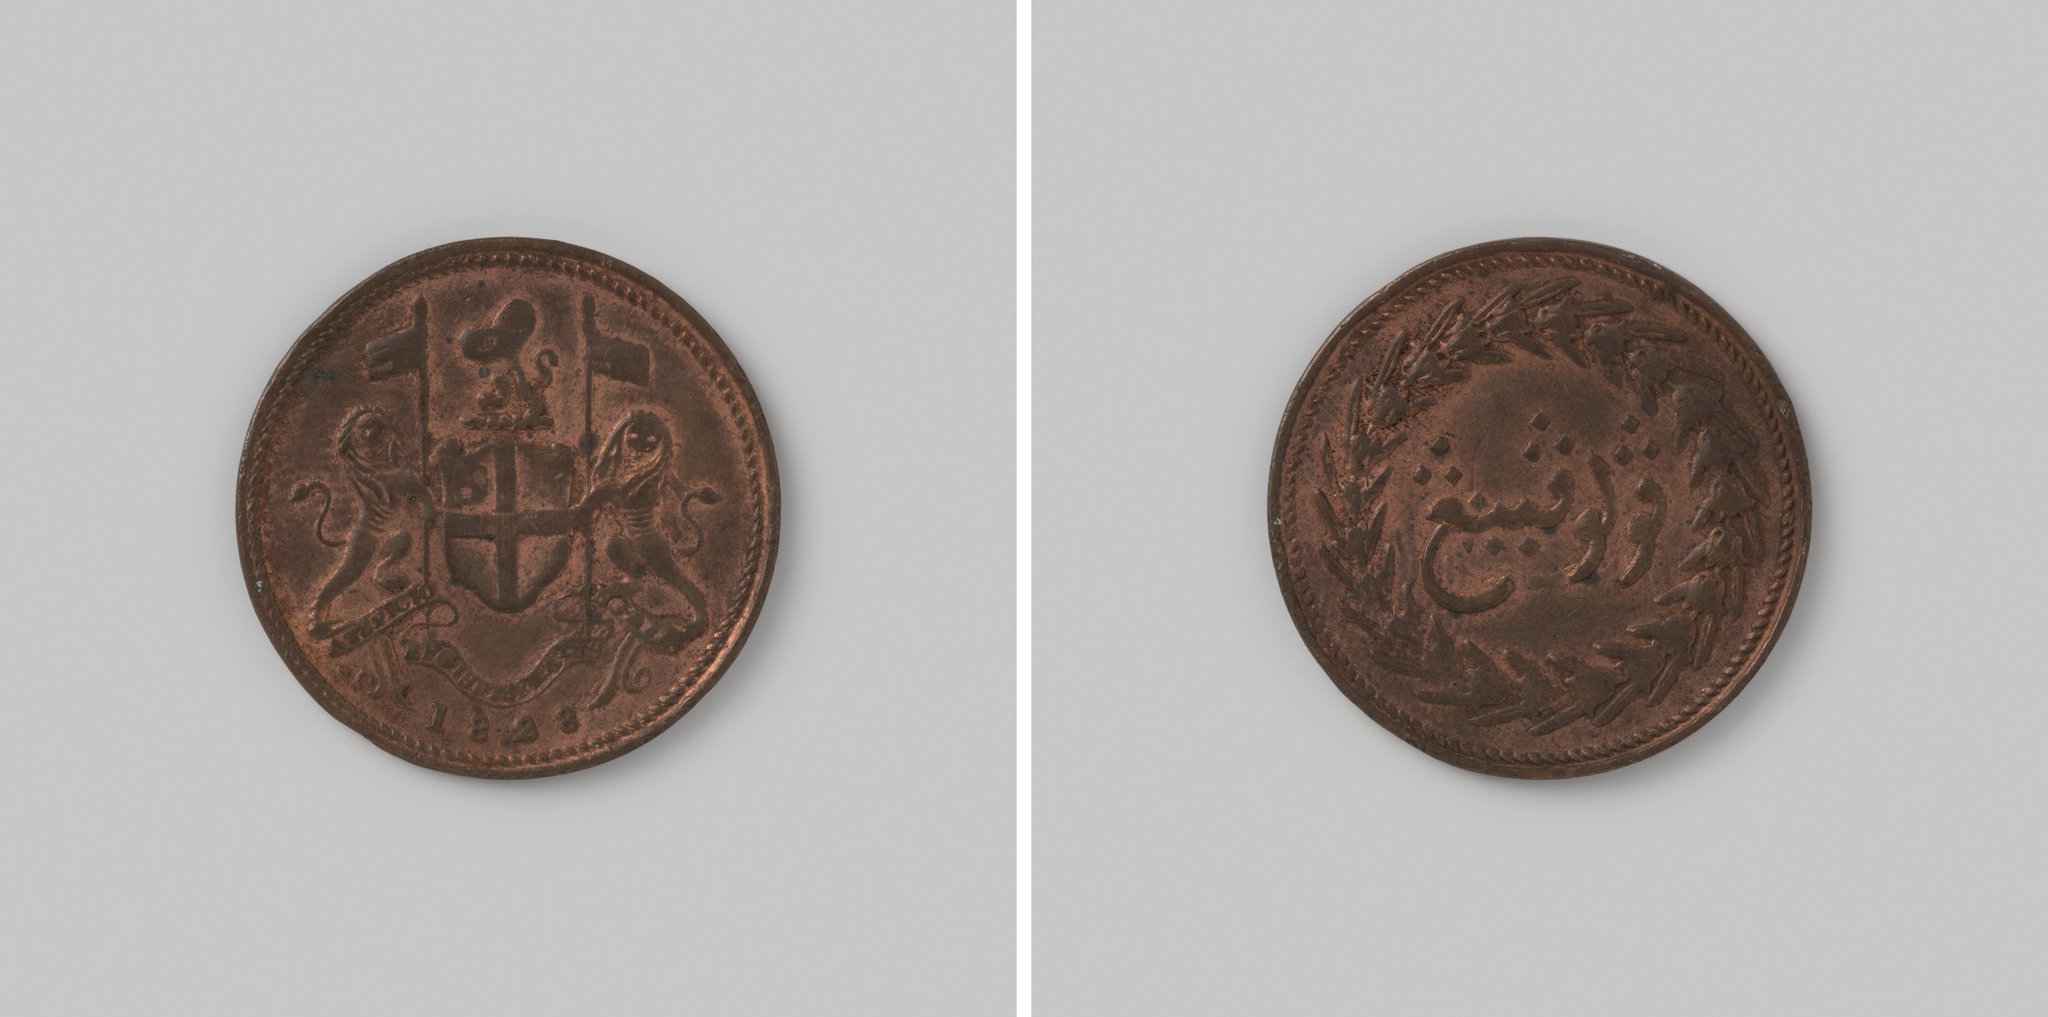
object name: coin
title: Malakka, Pulu Penang, ½ cent, 1828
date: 1828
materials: copper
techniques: striking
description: Koperen munt. Voorzijde: door twee op banderol, waarin opschrift, staande leeuwen met pijl, waaraan vlag, in de klauw, gehouden wapenschild van de EIC, waarboven helmteken. Jaartal onderaan. Keerzijde: binnen krans van bladeren eenregelig opschrift in het Maleis in Arabische lettertekens: pulu penang.